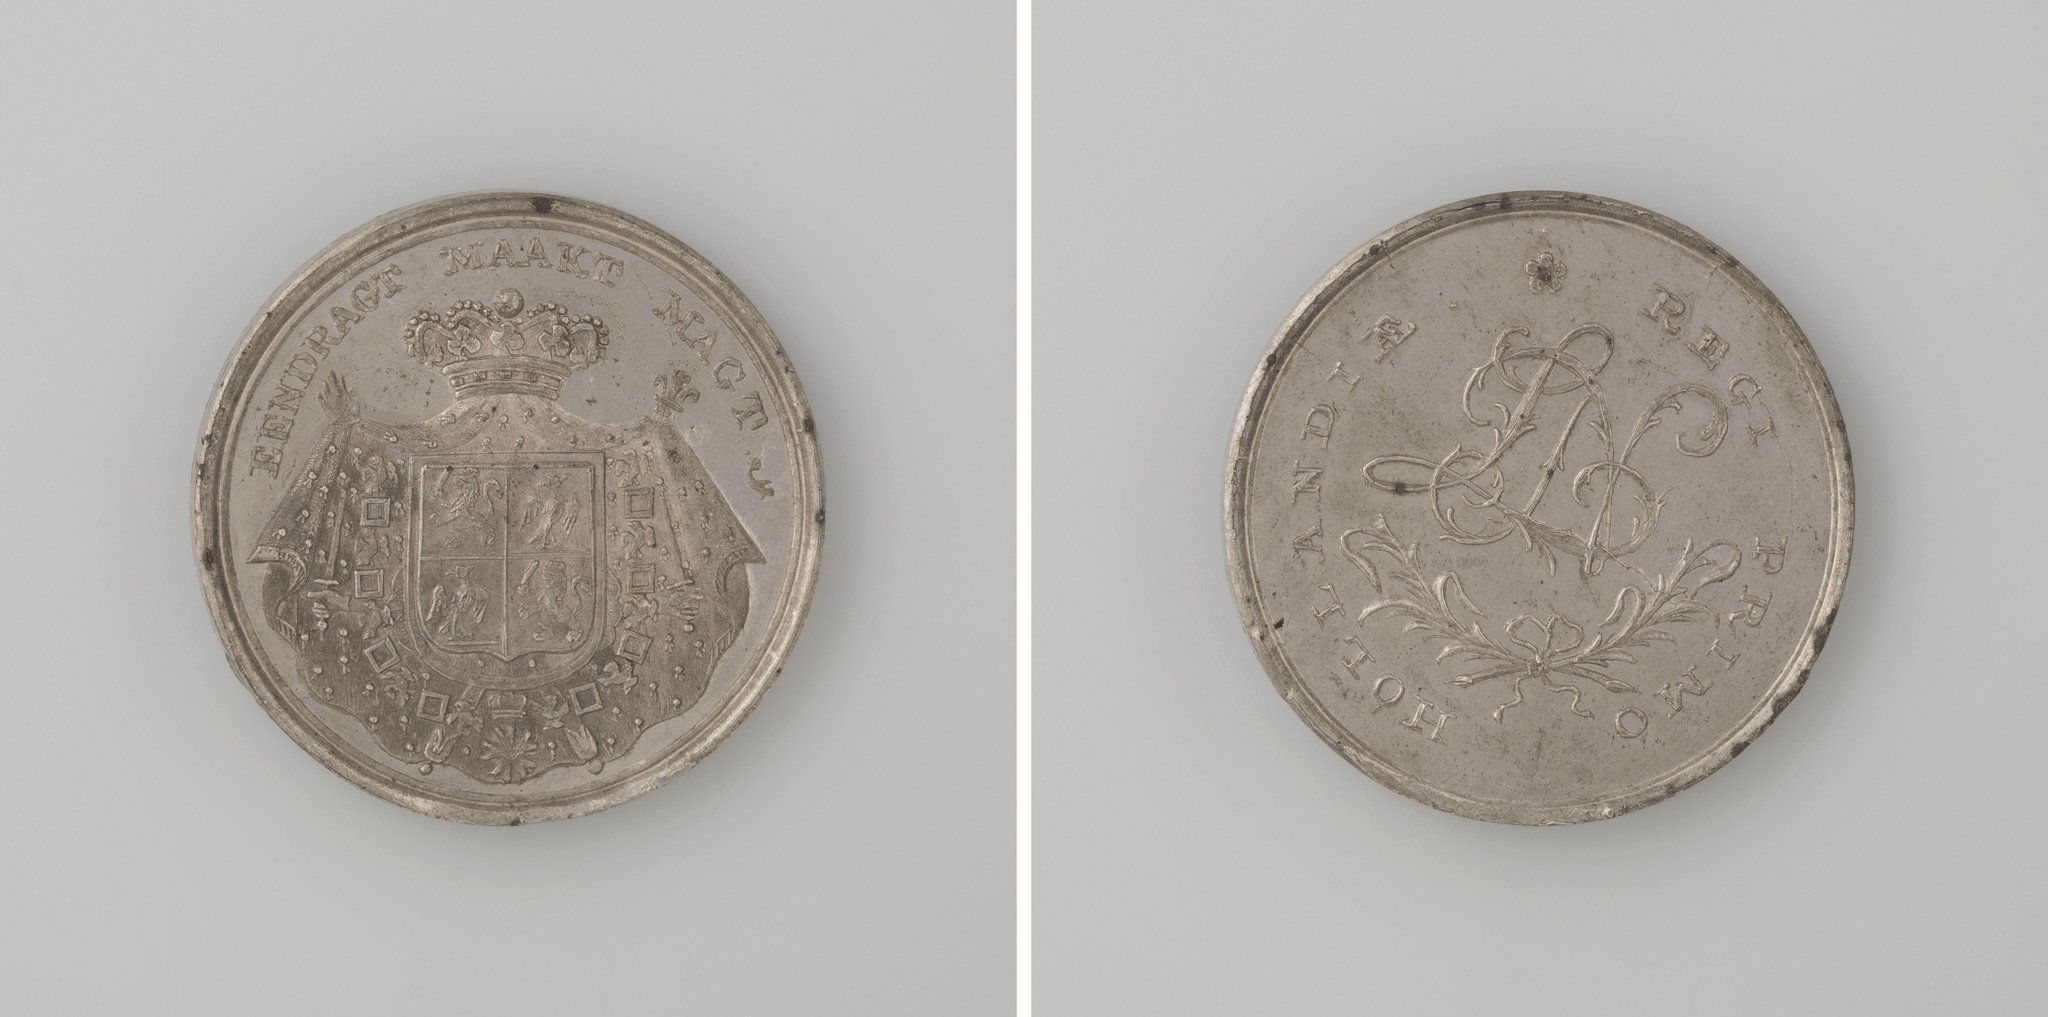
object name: history medal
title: Lodewijk Napoleon, koning van Holland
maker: Anonymous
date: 1808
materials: metal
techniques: silvering, striking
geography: netherlands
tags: louis napoleon (king of holland)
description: Voorzijde: gekroond wapenschild binnen omschrift. Keerzijde: monogram van Lodewijk Napoleon boven twee samengebonden takken binnen omschrift